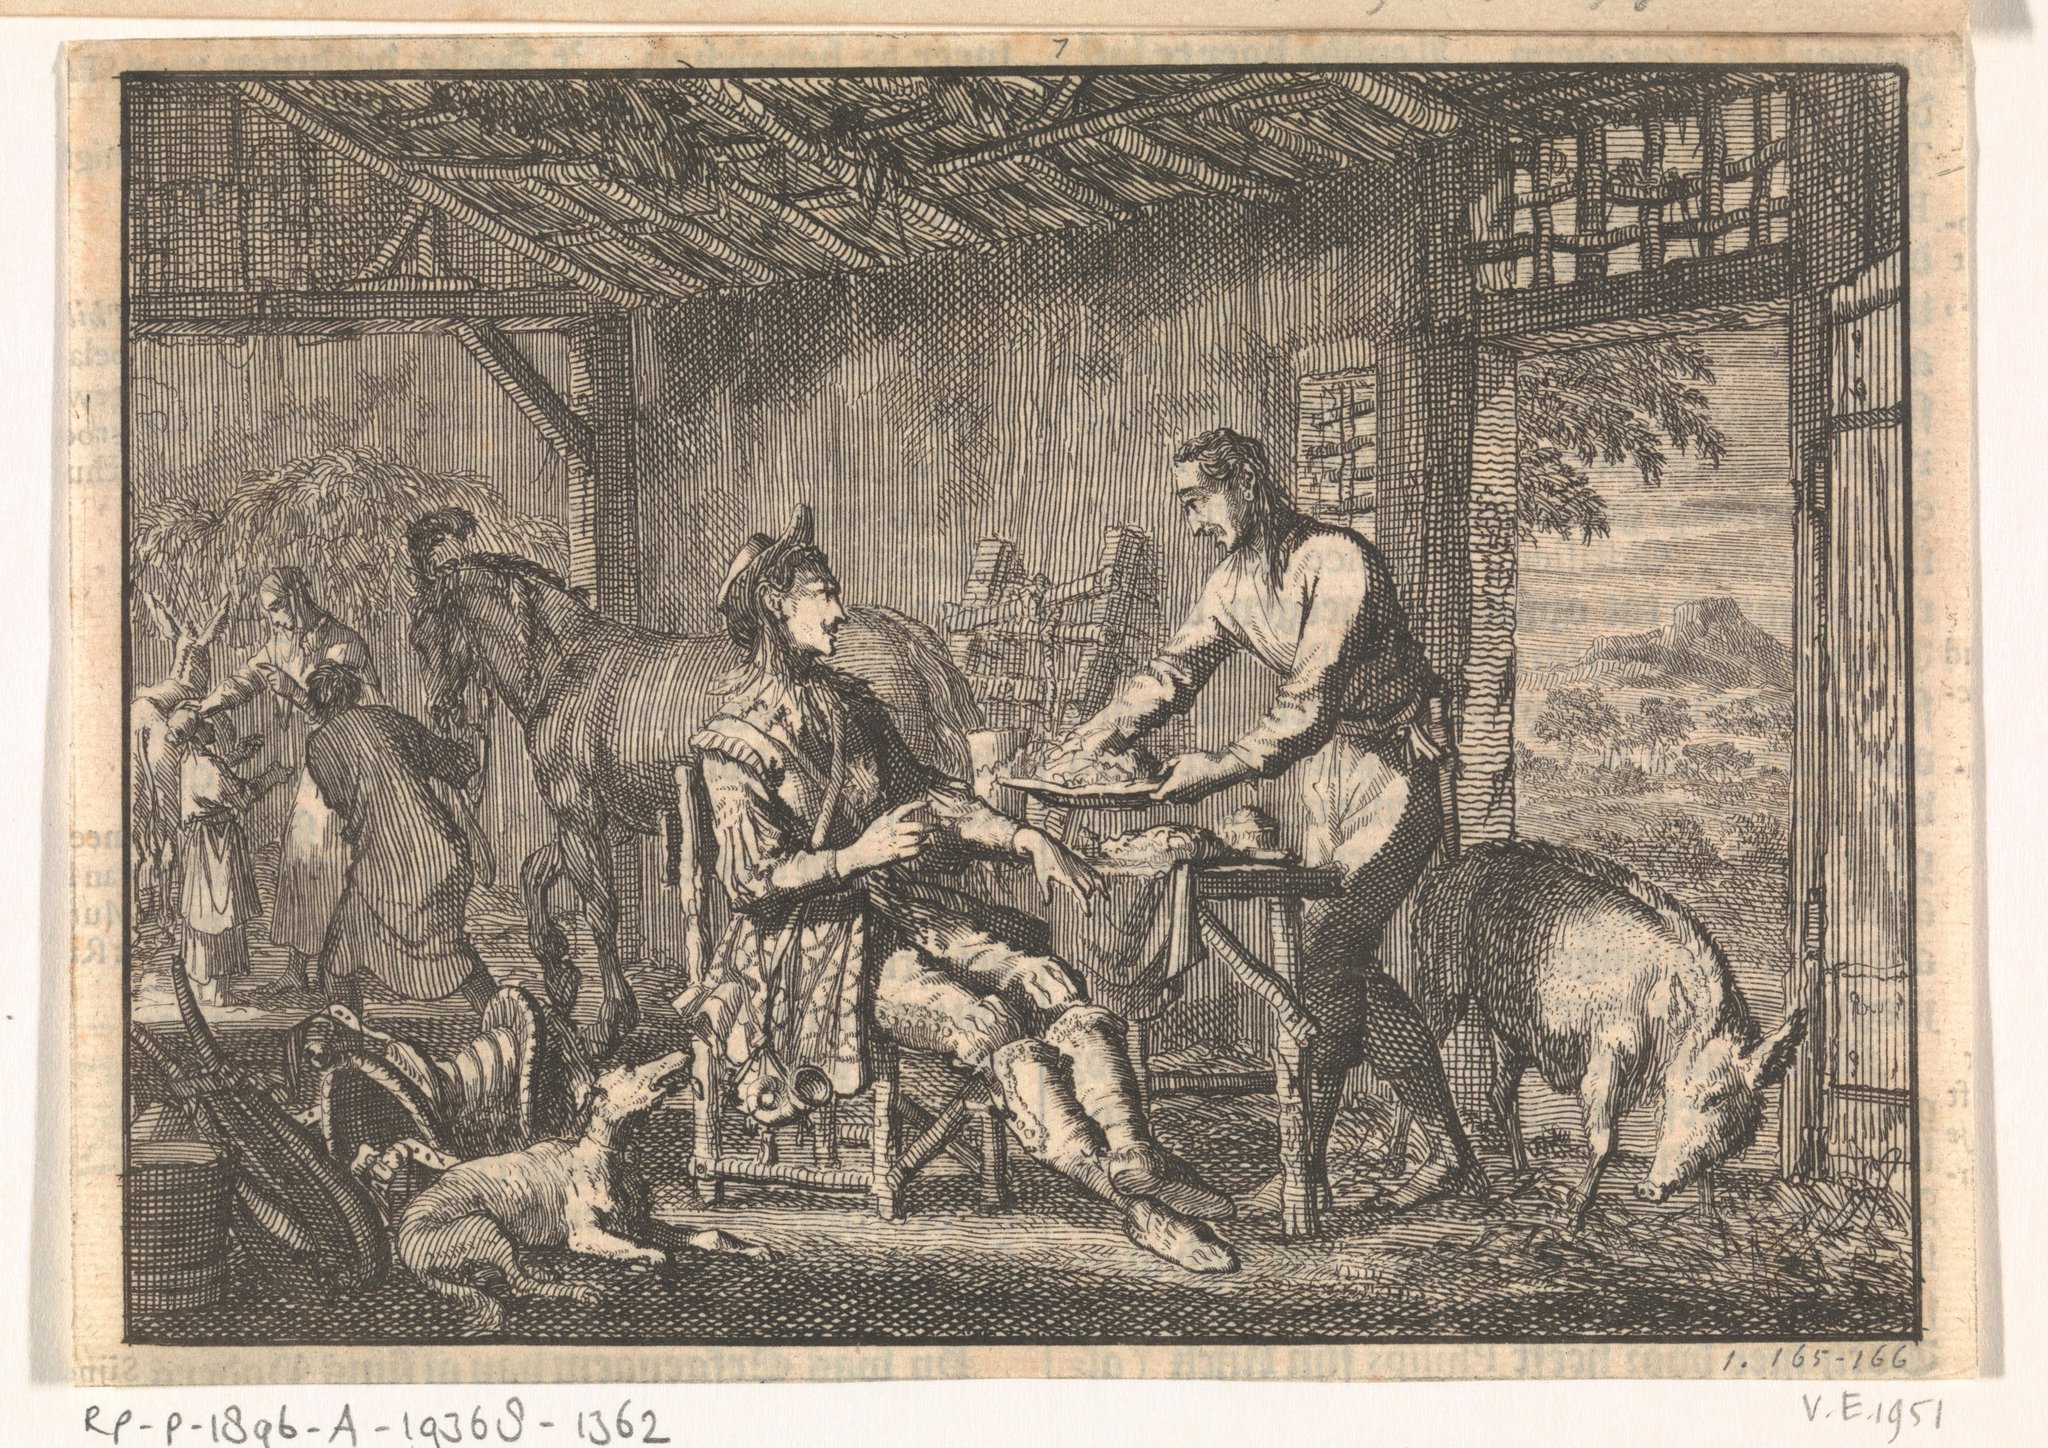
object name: book illustration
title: Philips II, koning van Spanje wordt opgenomen in de hut van een arme boer, ca. 1560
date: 1698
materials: paper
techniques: etching, letterpress printing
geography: leiden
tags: philip ii of spain, farm (building) - aa - civic architecture: inside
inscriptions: collector's mark: Lugt 2228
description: Illustratie uit: Gottfried, Johann Ludwig. Historische kronyck; vervattende een (...) beschrijvingh der aldergedenckwaerdigste geschiedenissen des weerelds, van den aenvangh der scheppingh tot (...) 1576 (2 delen). Leiden: Pieter van der Aa, 1698, dl. I, p. 165.